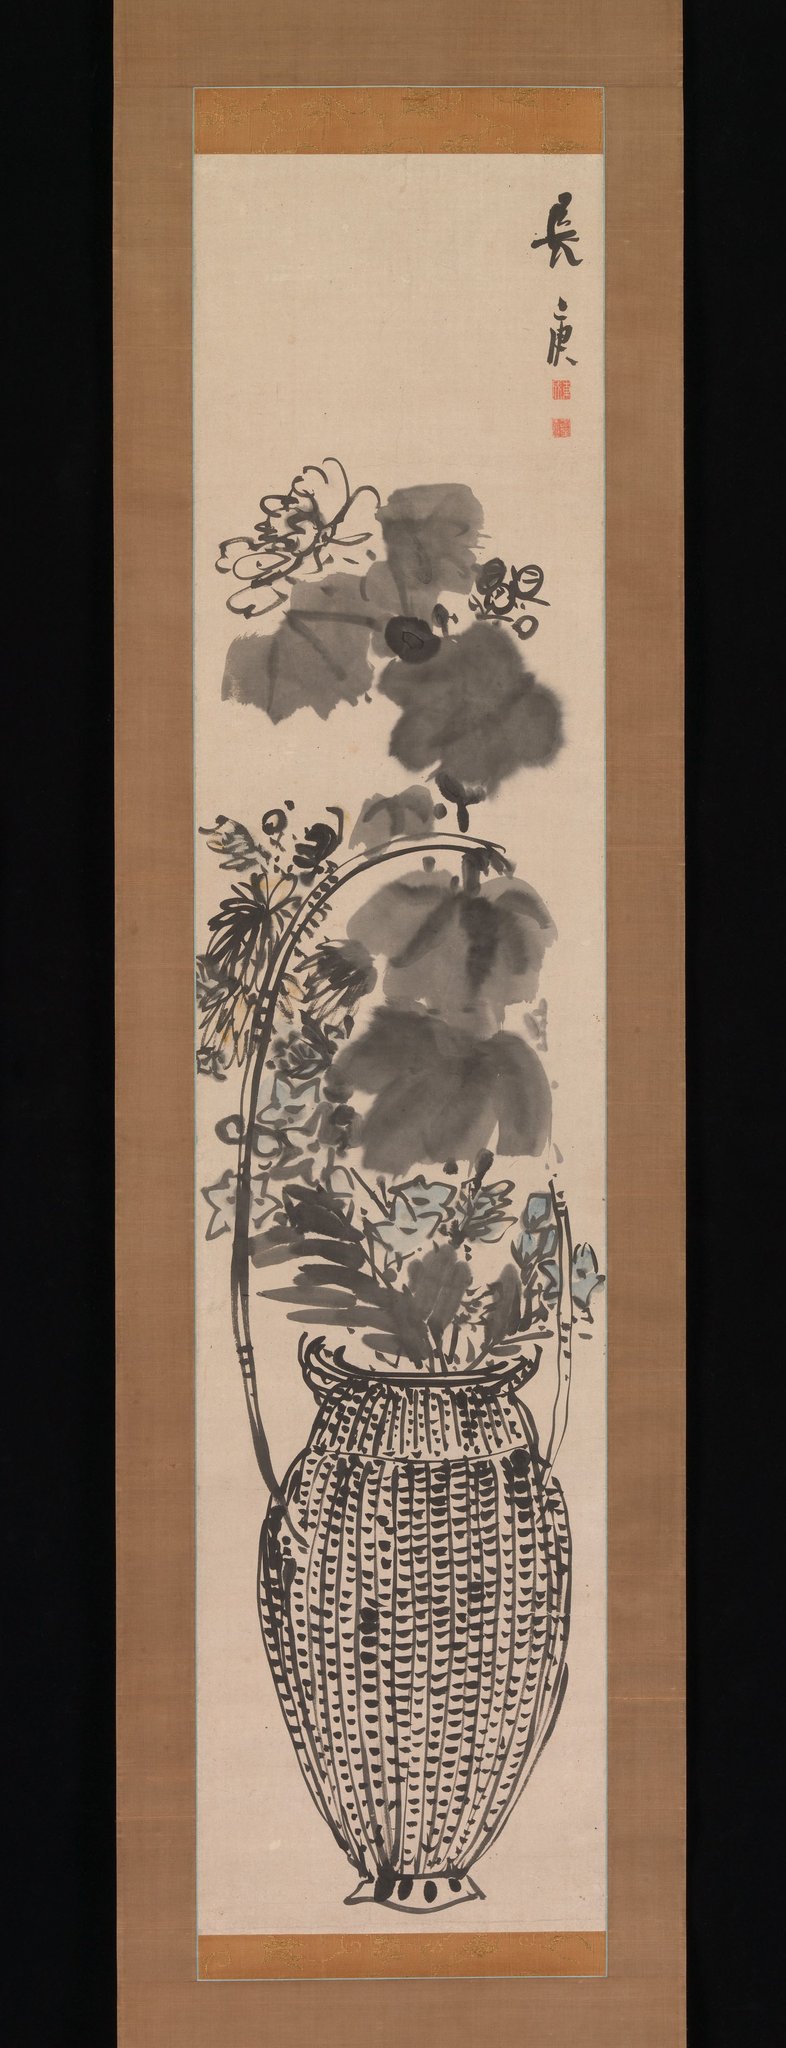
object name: hanging scroll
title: Autumn Flowers in a Bamboo Basket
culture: japanese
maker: yosa buson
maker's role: artist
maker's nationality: japanese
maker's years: 1716-1783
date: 1760-1769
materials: ink, paper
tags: flowers